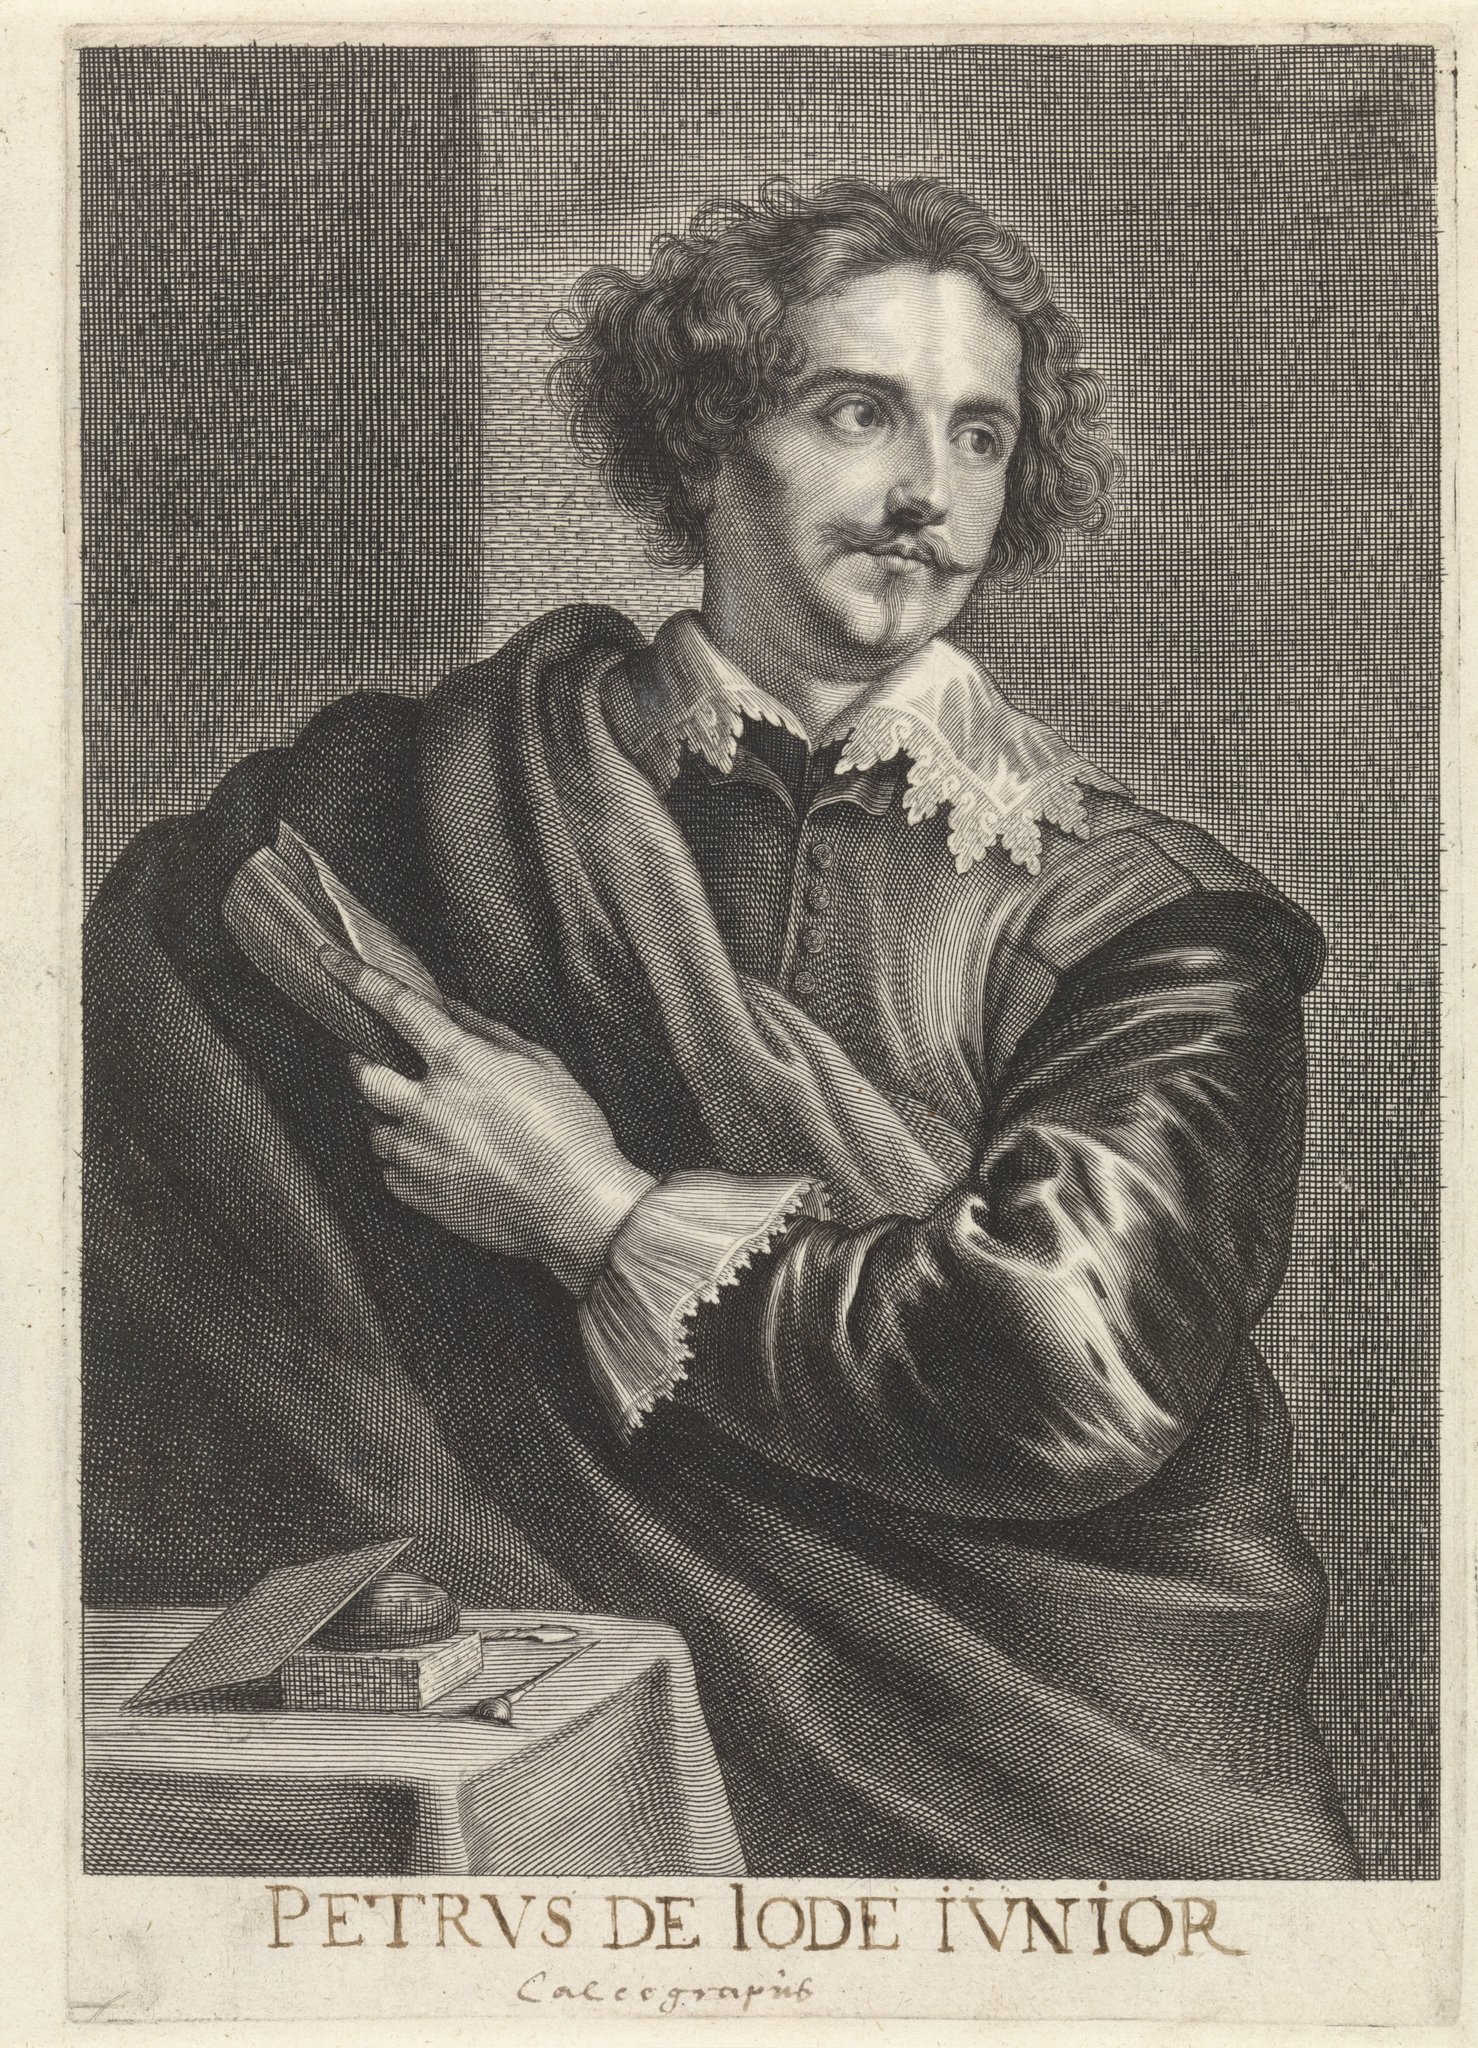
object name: print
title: Portret van Pieter de Jode (II)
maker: pieter de jode (ii)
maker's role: draughtsman, print maker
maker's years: 1606-1674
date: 1628-1670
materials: paper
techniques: engraving, etching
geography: antwerp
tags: tools, implements of graphic artist, scroll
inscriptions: inscription: ‘Petrvs de Iode Ivnior Caleograp[?]’, collector's mark: Lugt 240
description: Portret van de kunstenaar Pieter de Jode (II), ten halven lijve. In zijn linkerhand houdt hij een opgerold vel papier. Op de tafel voor hem een graveernaald en andere attributen. In de marge de naam van de geportretteerde (handgeschreven).